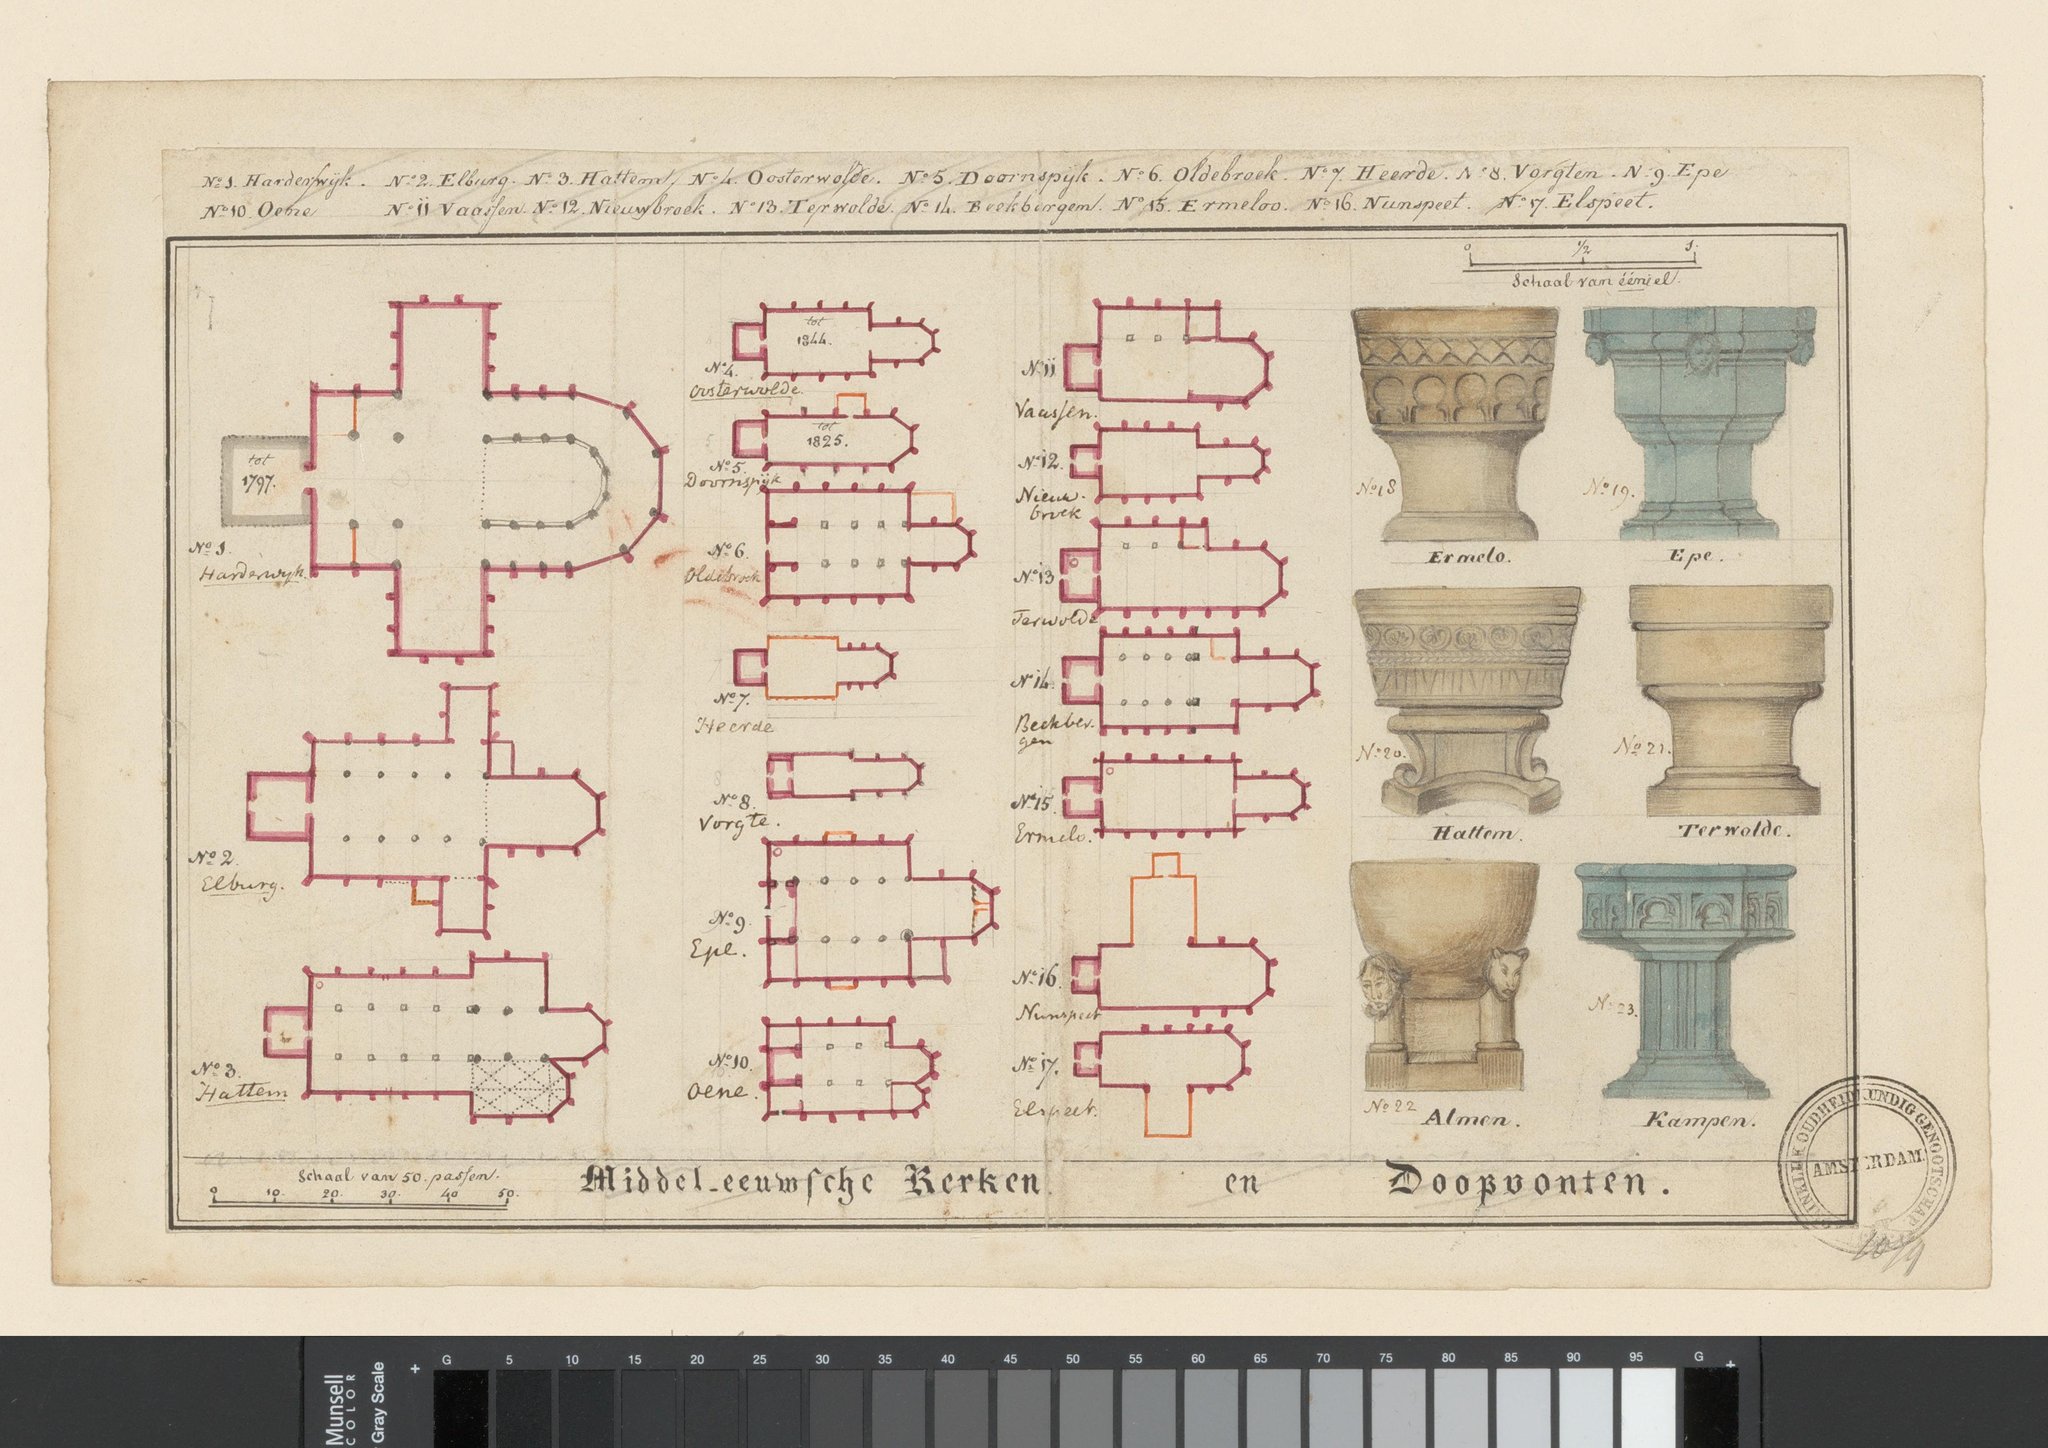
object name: drawing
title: Plattegronden van kerken en zes doopvonten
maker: leendert springer (i)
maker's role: draughtsman, painter, print maker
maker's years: 1789-1871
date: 1850-1852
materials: paper, pencil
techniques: brush, pen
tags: baptismal font, plan ~ architecture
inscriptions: collector's mark: ‘Koninklijk Oudheidkundig Genootschap Amsterdam’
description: Aan de linkerzijde zeventien plattegronden van kerken uit de middeleeuwen. Rechts zes doopvonten. Bij iedere afbeelding staat een nummer en de schaal van de verbeelden objecten op ware grote. Onderwerpsrubrieken binnen de Atlas Zeden en Gewoonten: Godsdienst, Roomsch-Katholieken, Processies, Herinneringen.